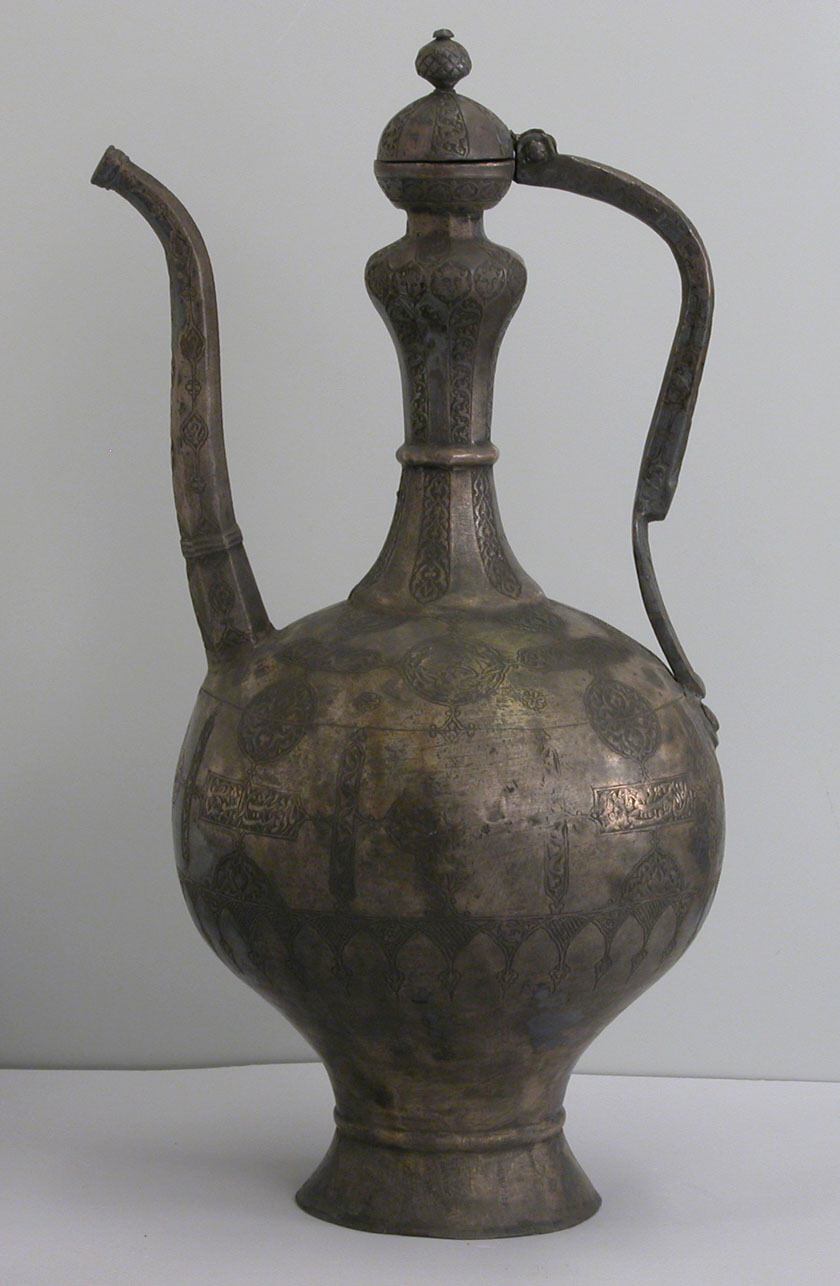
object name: ewer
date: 1701-1800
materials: bronze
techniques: silvered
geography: iran